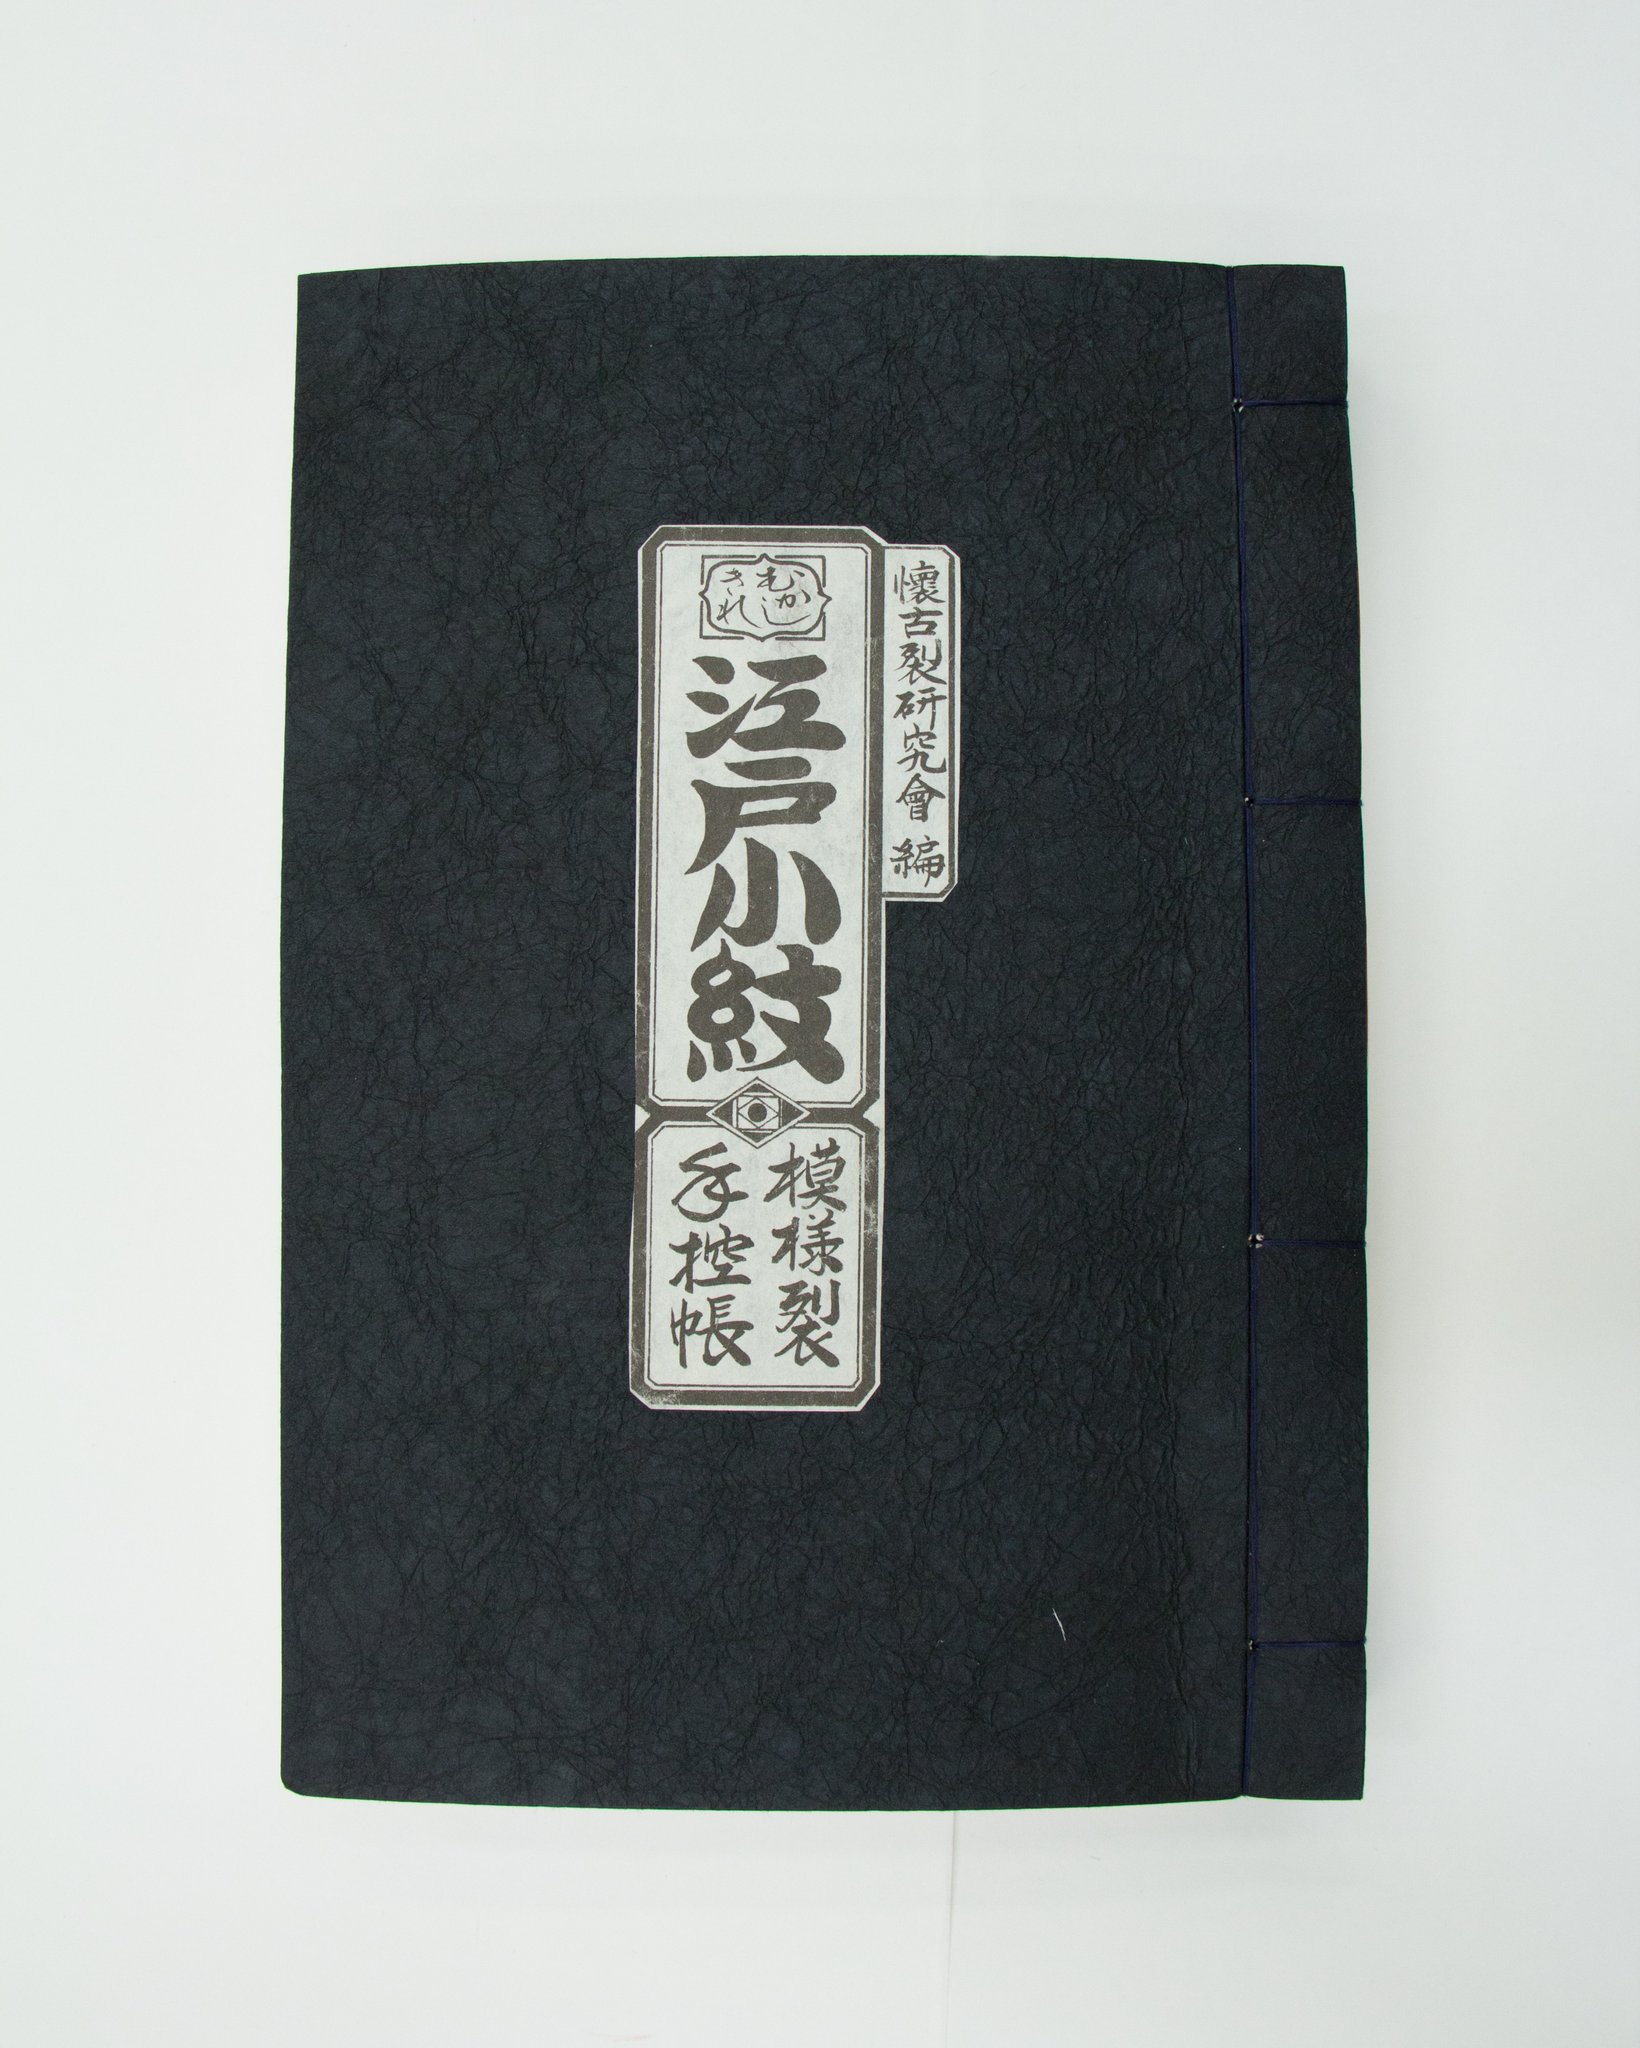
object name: textile sample book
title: Edo komon-monogire tebikaecho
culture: japanese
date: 1801-1900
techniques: dyeing